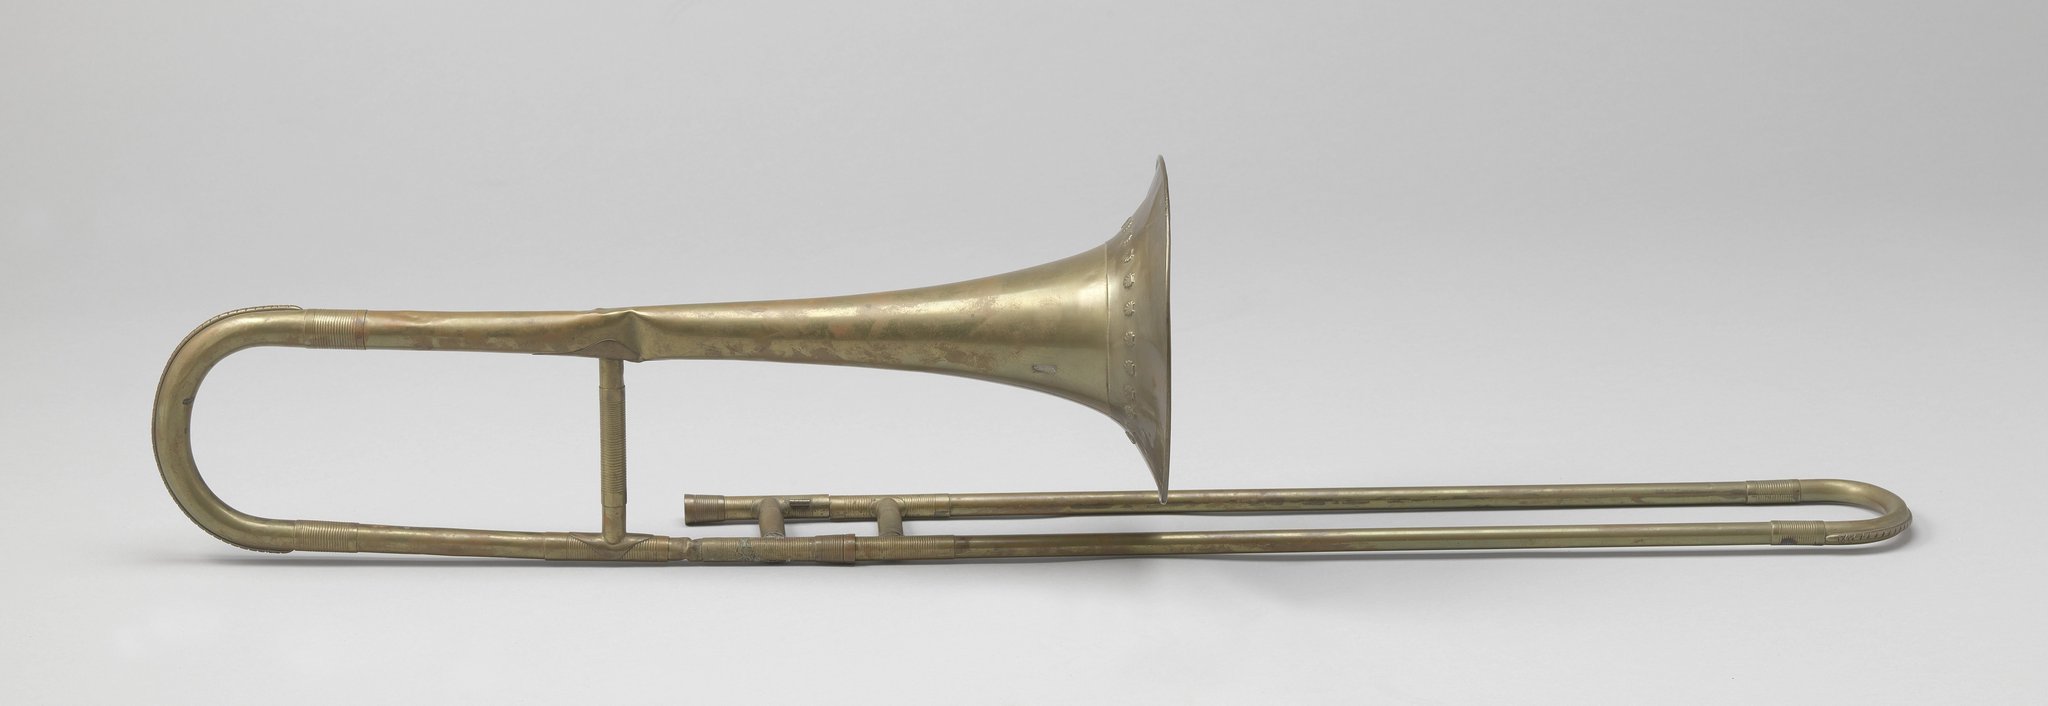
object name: musical instrument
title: Trombone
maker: Anonymous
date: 1850-1880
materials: copper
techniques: amalgam gilded, metalworking, casting, sawing, soldering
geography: germany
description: Trombone met éen klep en gedreven schelpjes op de beker. Verder twee delen van de schuif: een handvat met ribbels en soldeerresten en een gladde koperen buis die de binnenbuis is van de schuif en past in het volgende onderdeel. De coulisse, u-vormige beugel, met éen geribbeld en gesoldeerd handvat. Op het ronde deel van de beugel zitten dezelfde ribbels als op de beugel die vastzit aan de beker.